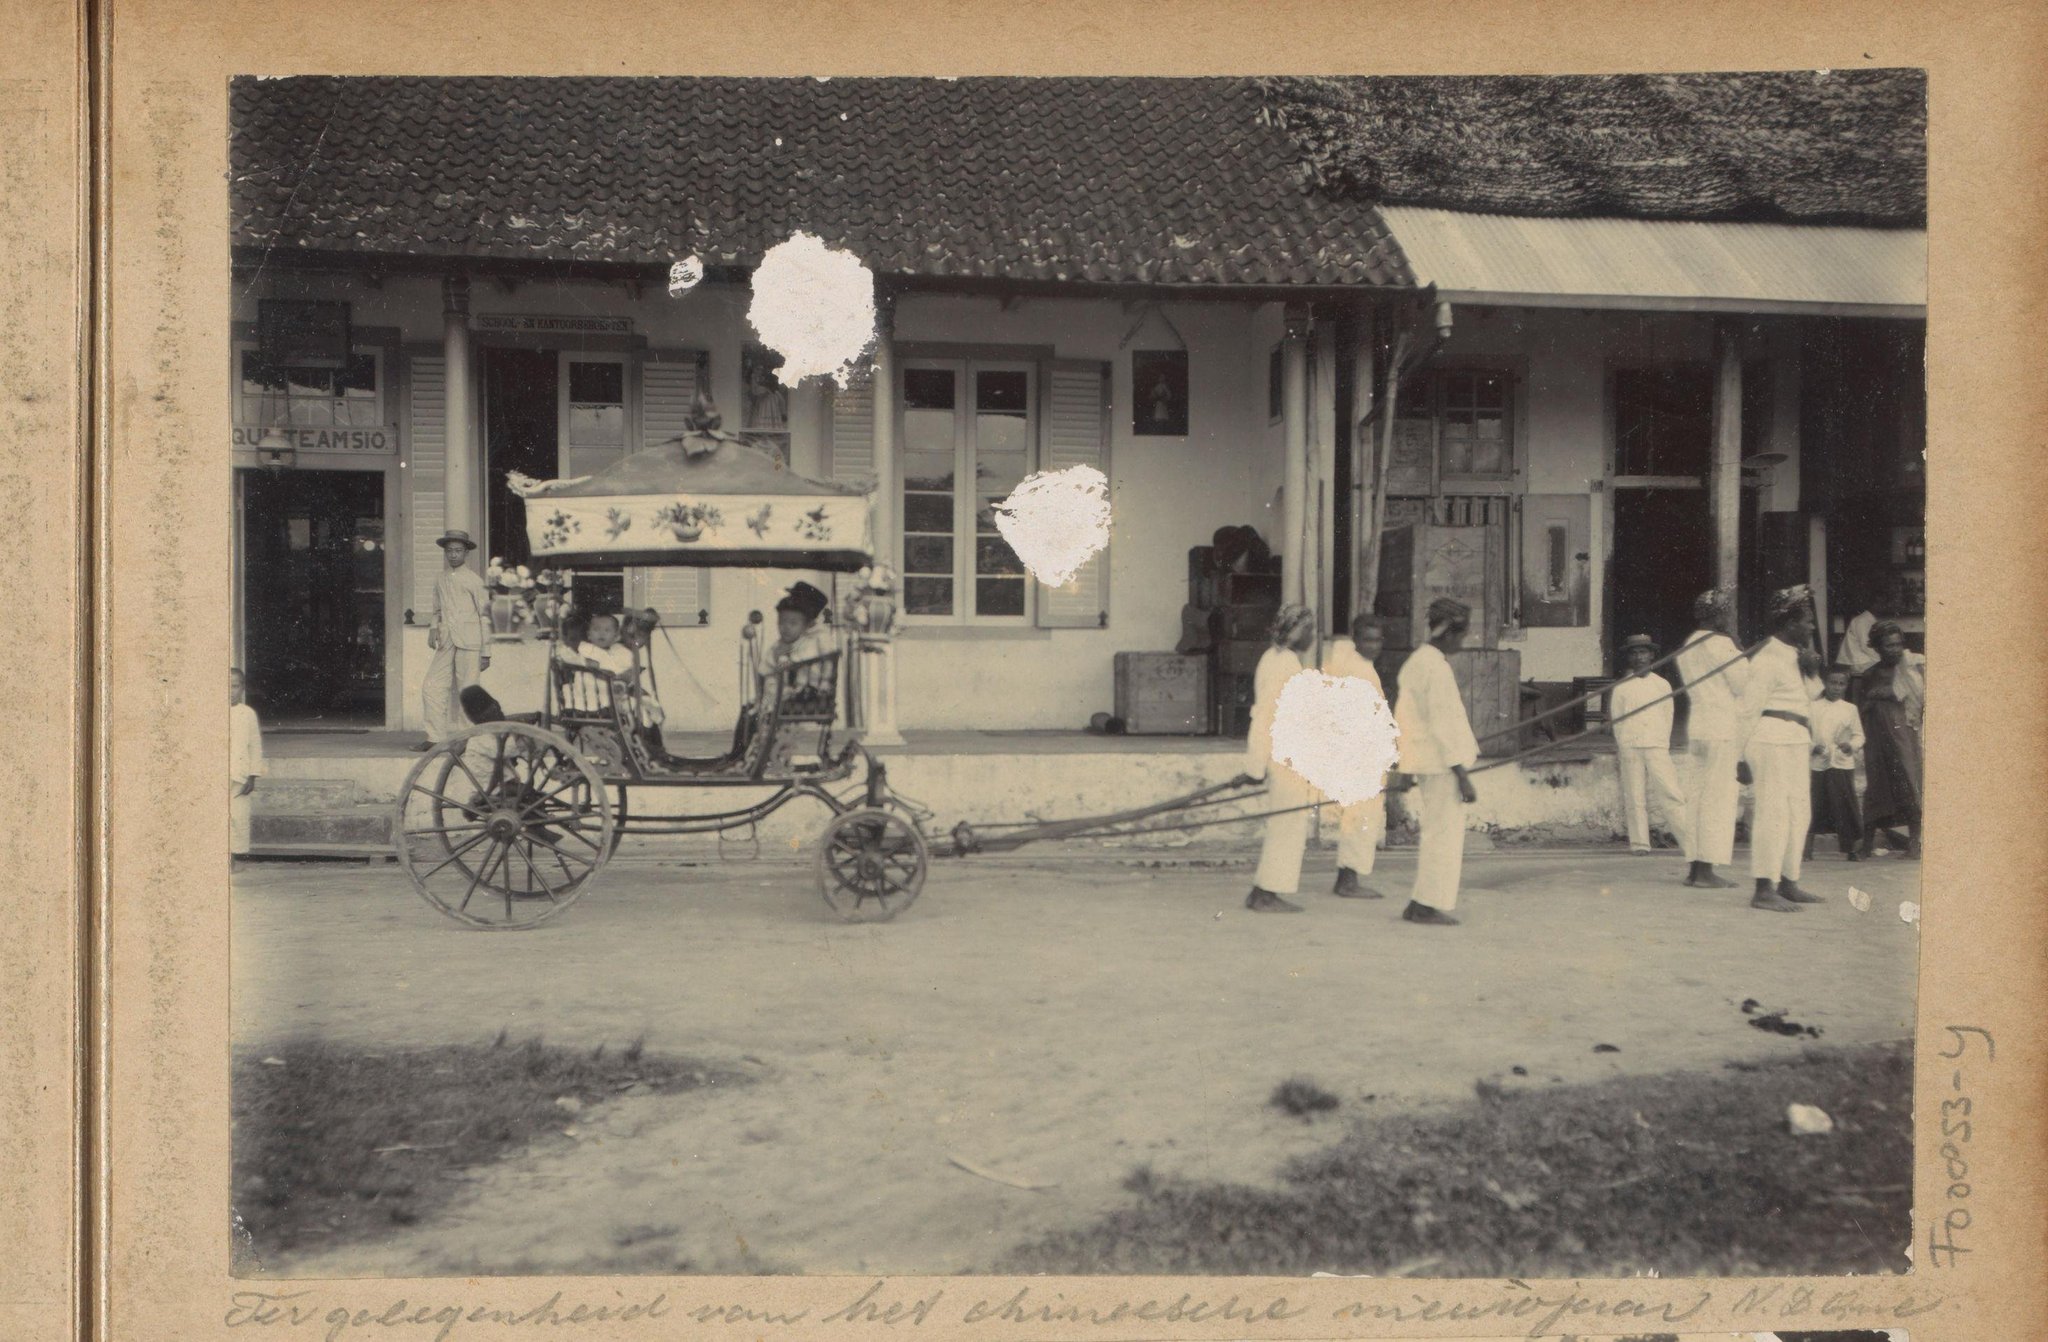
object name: photograph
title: Ter gelegenheid van het Chineesche nieuwjaar N. (...)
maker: Anonymous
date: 1900-1920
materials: cardboard, paper, photographic support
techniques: gelatin silver print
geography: ambon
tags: bus, coach, public festivities, dutch east indies, the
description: Onderdeel van Reisalbum met foto's van Ambon.